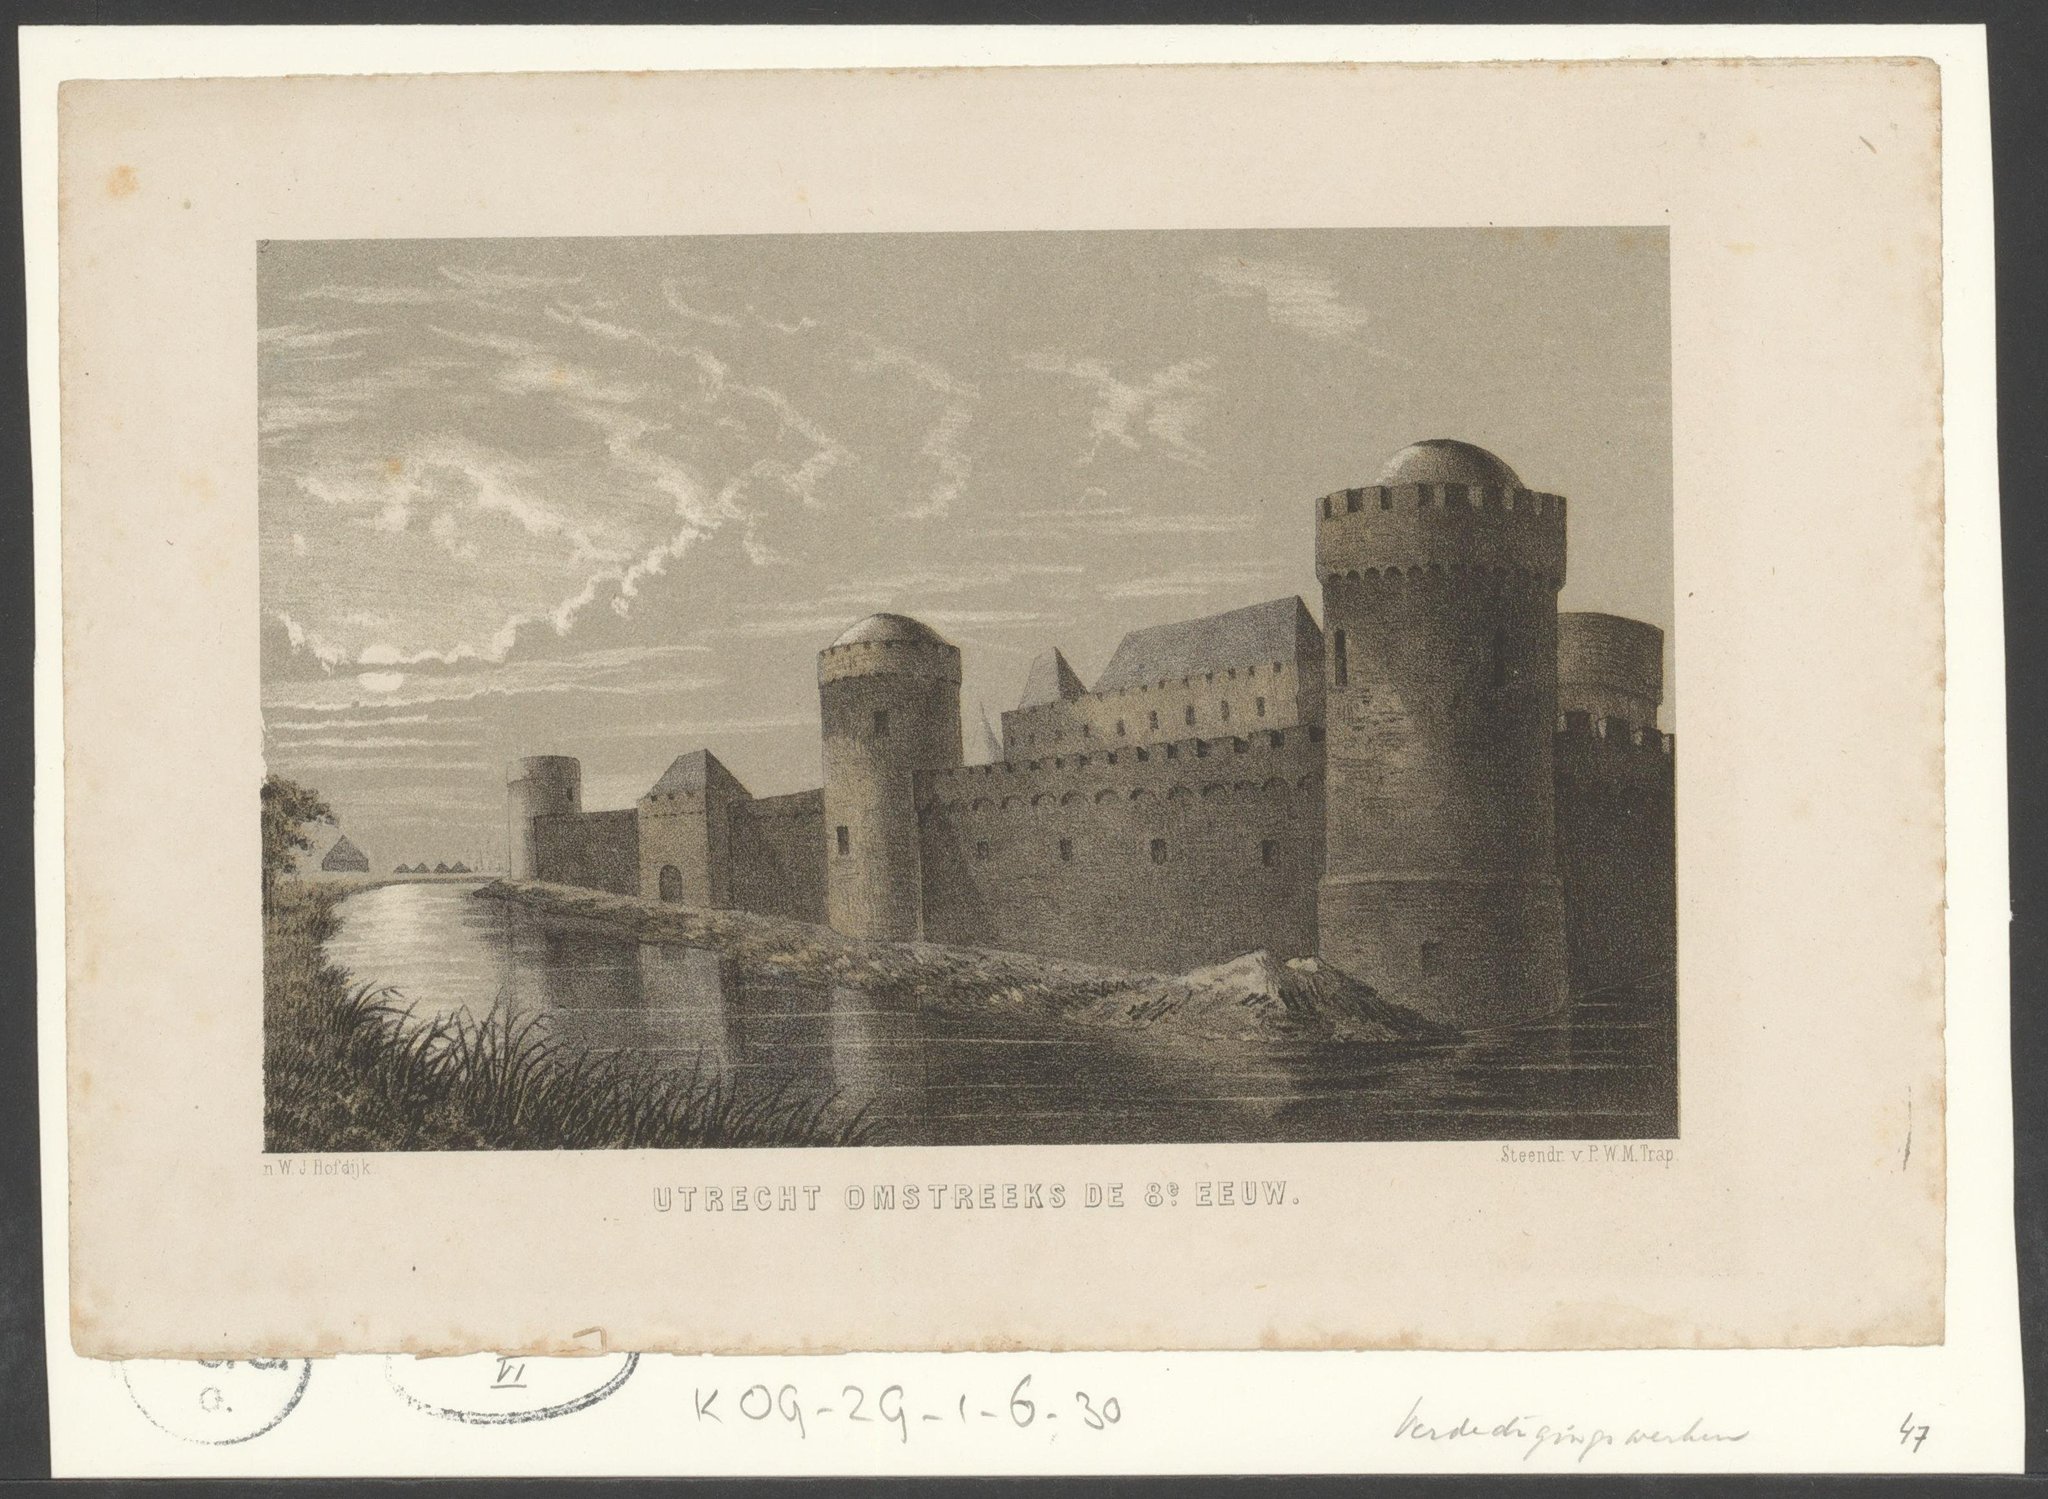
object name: print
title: Utrecht omstreeks de 8e eeuw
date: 1873-1875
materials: paper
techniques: tone lithography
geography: leiden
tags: castle, utrecht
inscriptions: stamp, collector's mark: Lugt 1641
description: Vestingmuur met torens en burcht, Utrecht omstreeks de 8e eeuw. Onderwerpsrubrieken binnen de Atlas Zeden en Gewoonten: Krijgswezen, Verdedigingswerken.